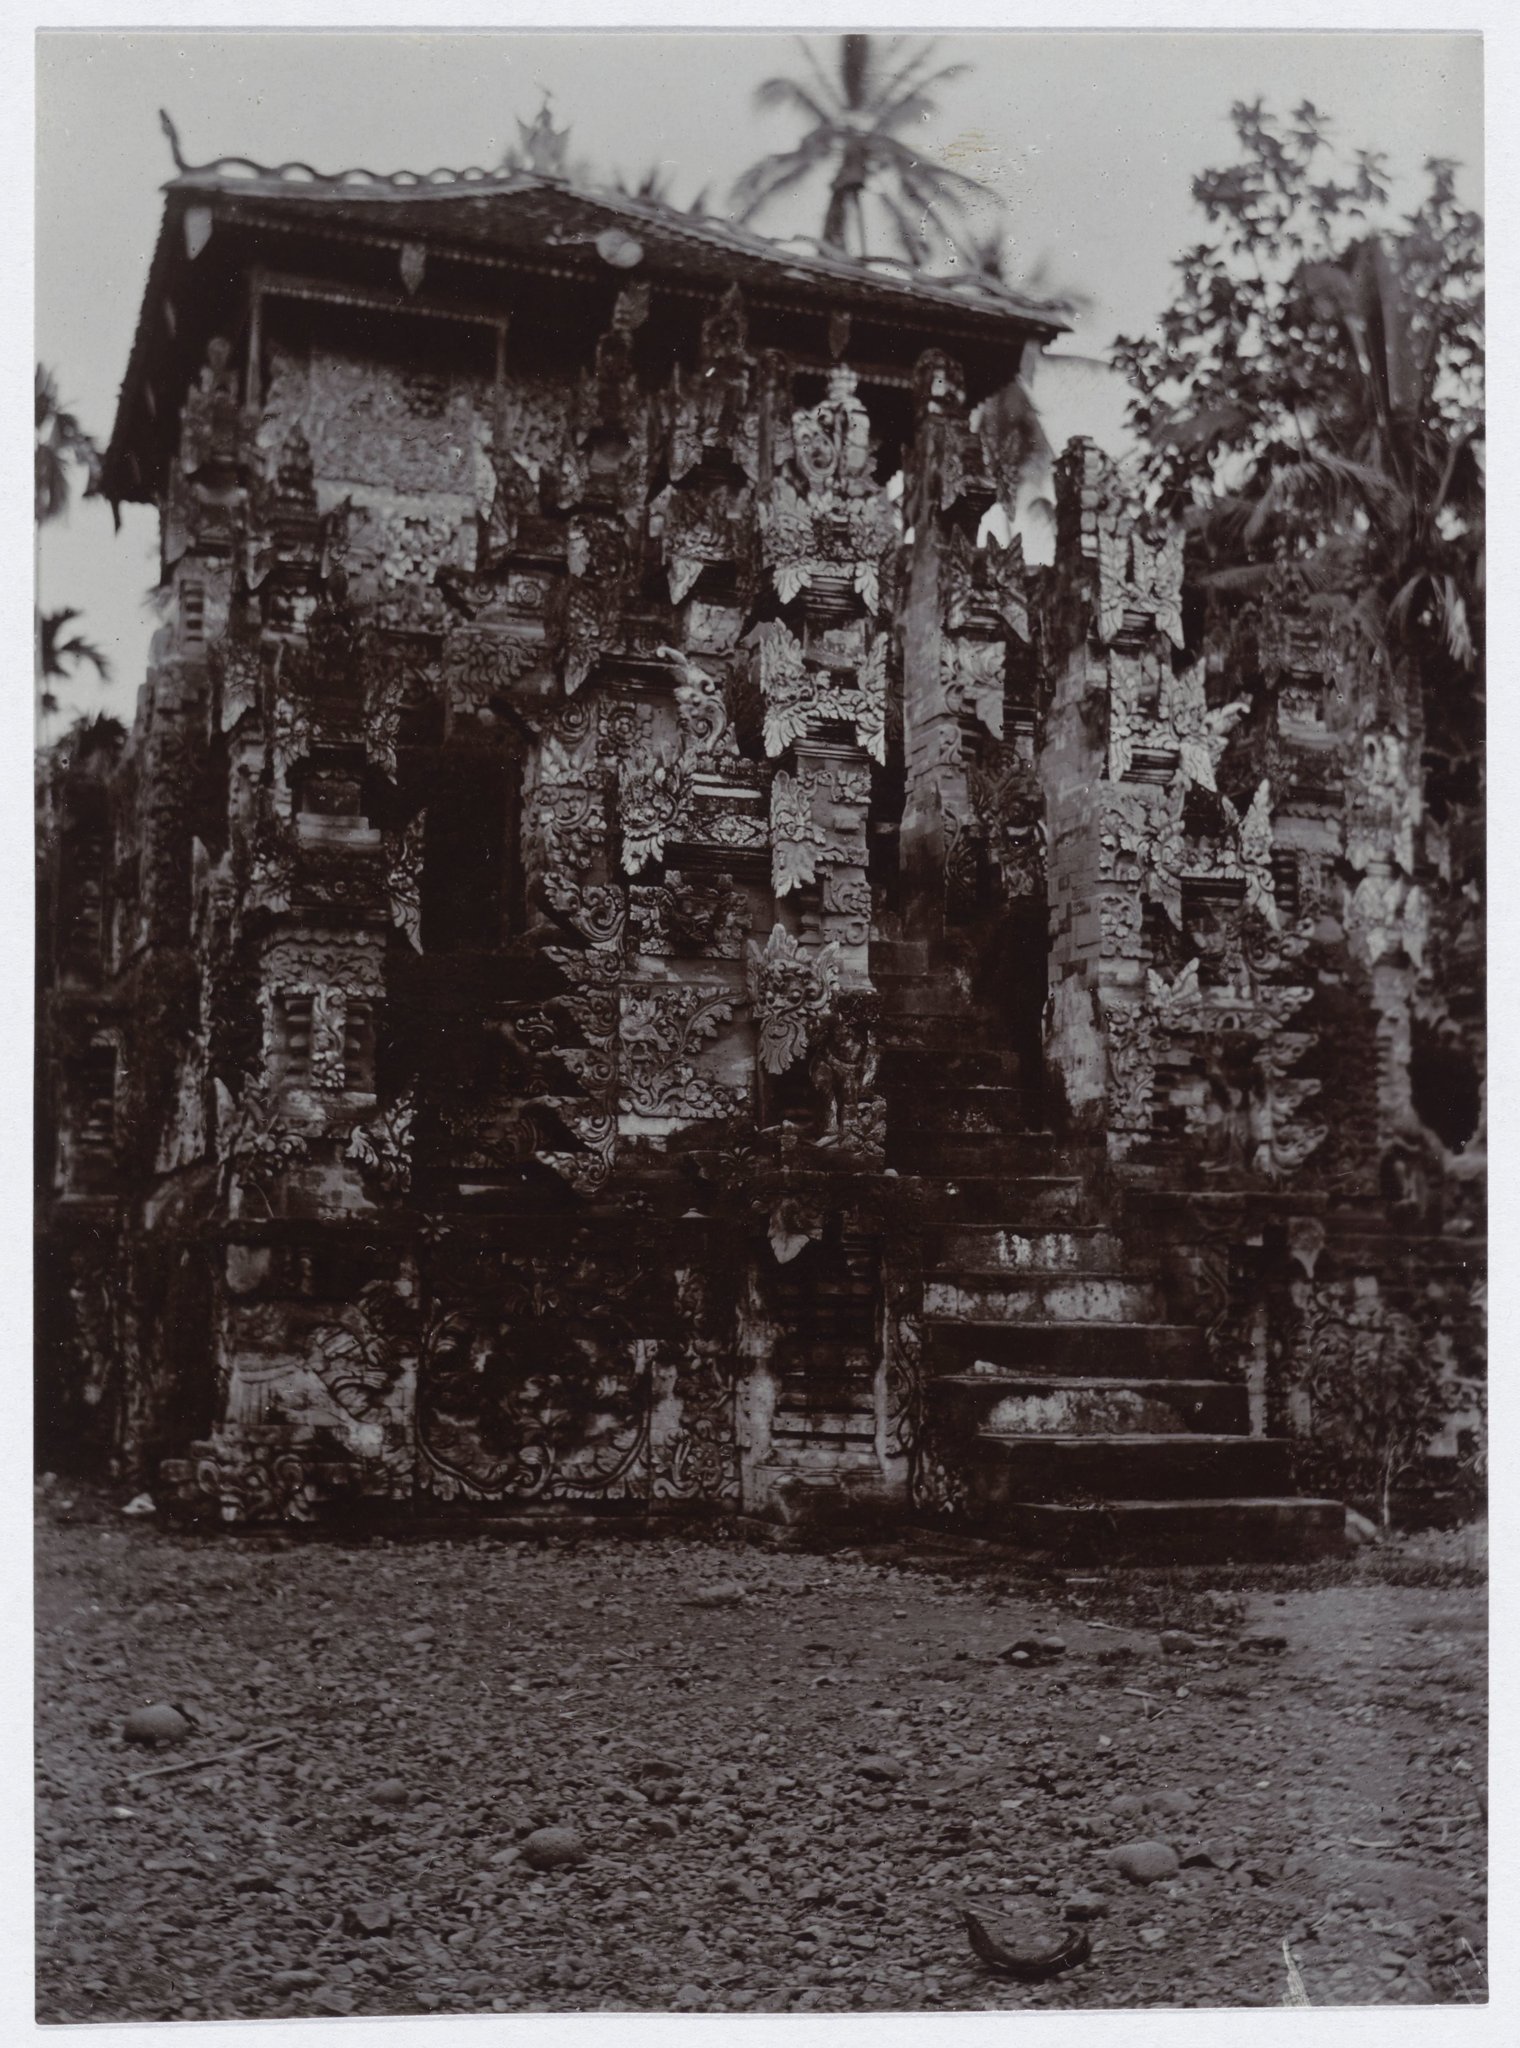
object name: photograph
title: 21. Noord-Bali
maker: johanna hermina marmelstein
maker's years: 1897-1990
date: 1900-1915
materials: paper, photographic support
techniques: albumen print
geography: jakarta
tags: bali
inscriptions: annotation: ‘21. Noord-Bali. Binnenpoort v/d poera te Sangsit bij Singaradja.’